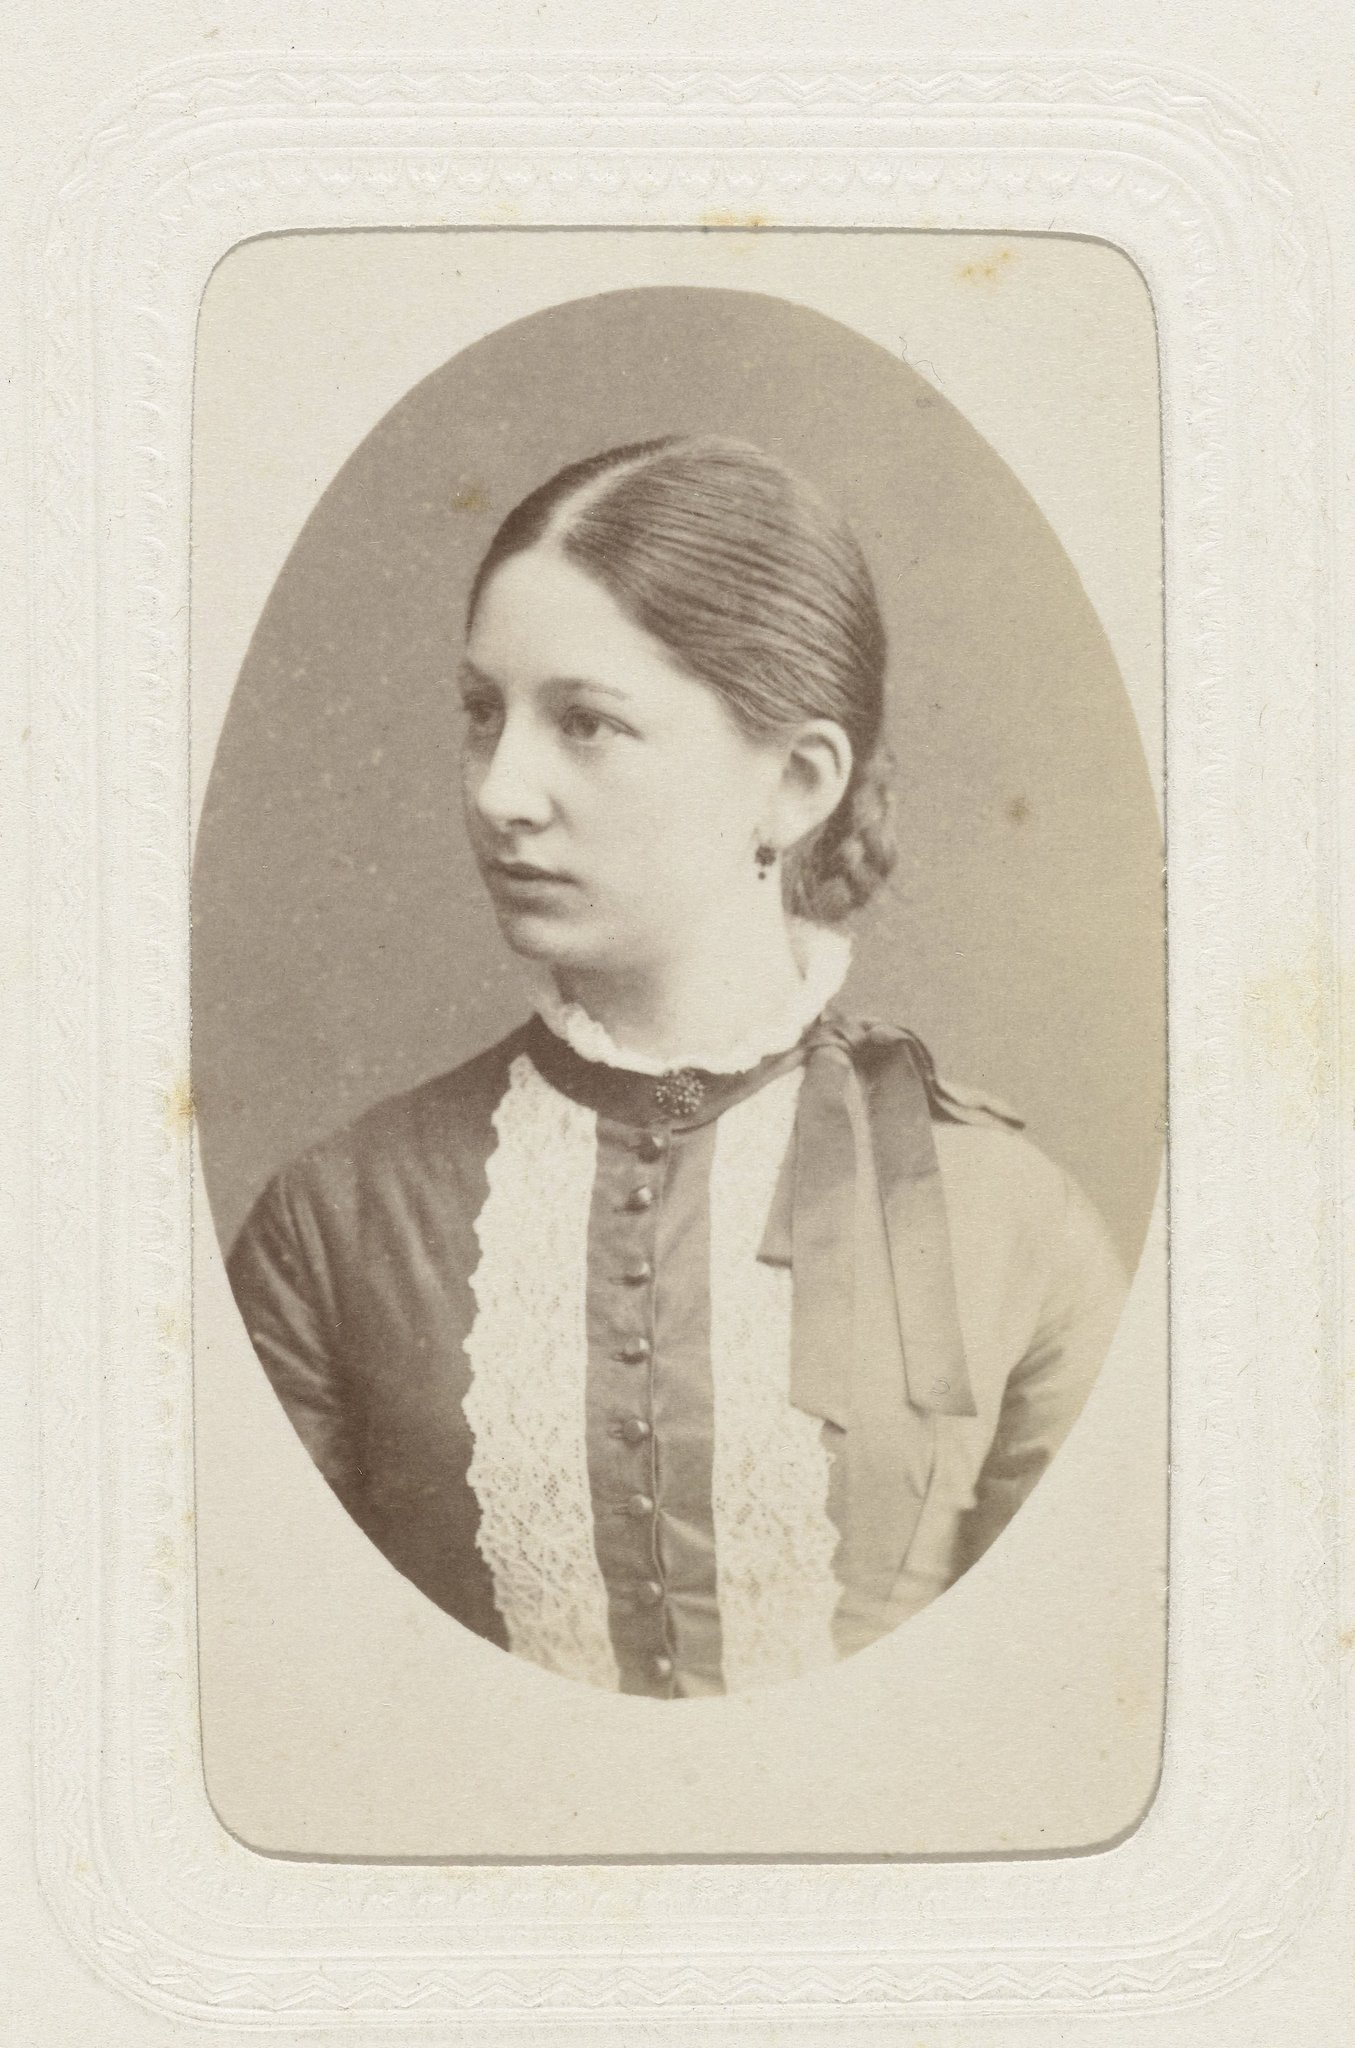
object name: carte de visite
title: Studioportret van een jonge vrouw in een hooggesloten jurk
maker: max büttinghausen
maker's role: fotograaf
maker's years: 1847-1906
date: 1863-1866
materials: cardboard, paper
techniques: albumen print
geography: amsterdam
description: De dame draagt oorbellen en opgestoken haar in een vlecht naar achteren opgerold.